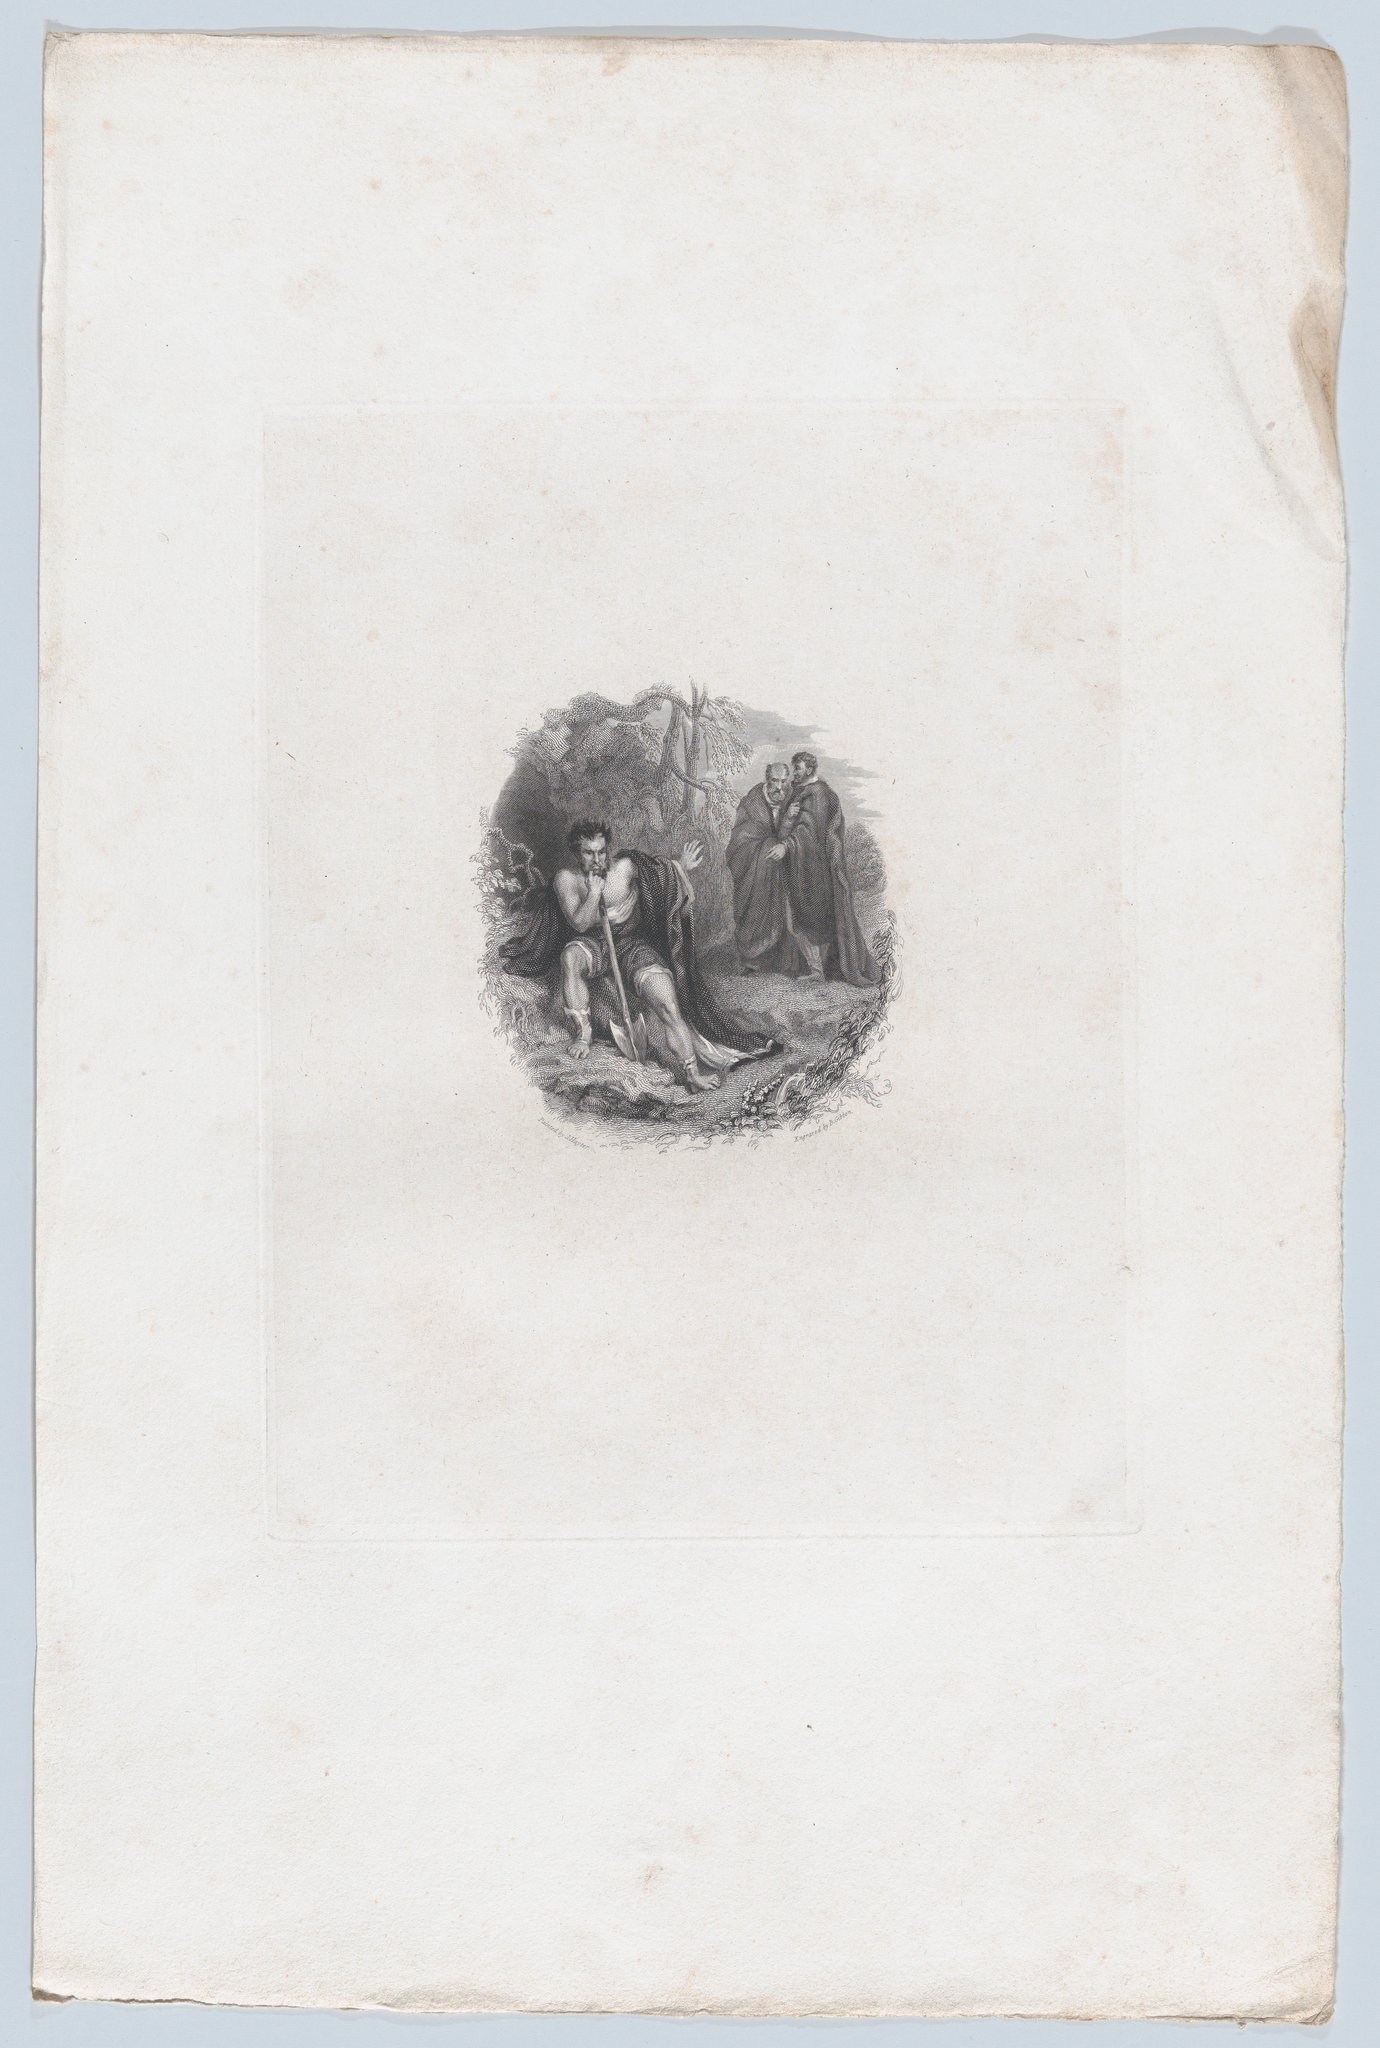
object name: print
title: Timon (Shakespeare, Timon of Athens, Act 4, Scene 3)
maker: benjamin phelps gibbon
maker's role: engraver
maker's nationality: british, born wales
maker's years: 1802-1851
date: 1827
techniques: printmaking, engraving, etching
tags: shakespeare,men